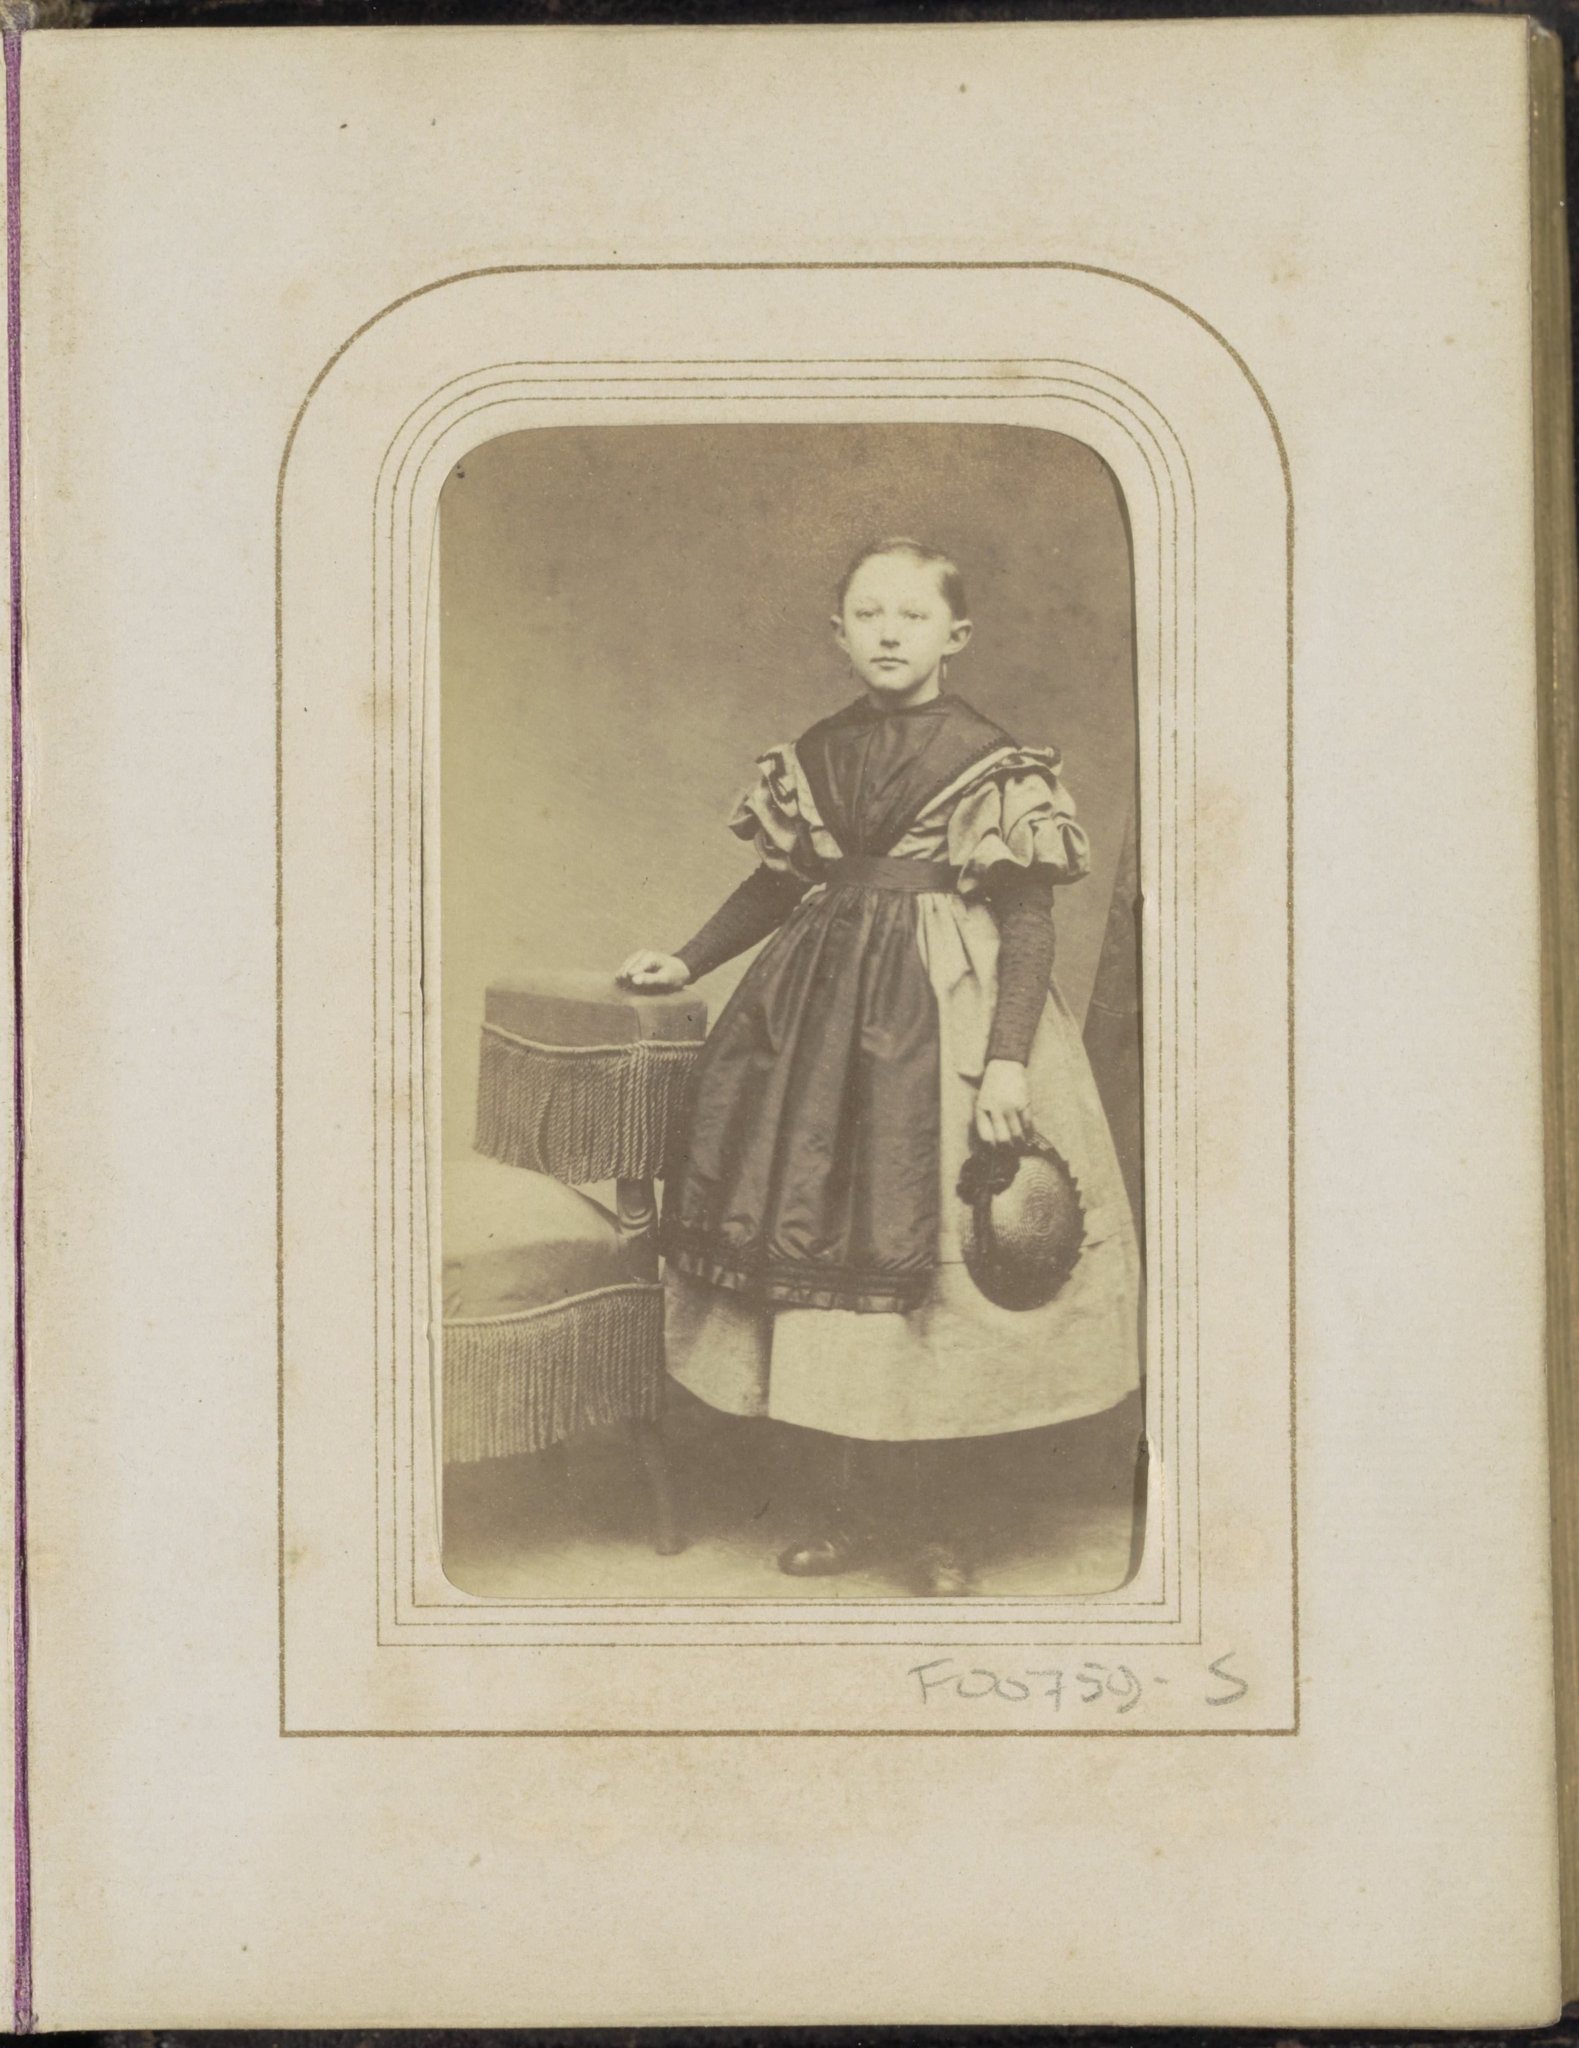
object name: photograph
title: Portret van een meisje met een schort en een hoed in de hand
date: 1863-1885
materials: cardboard, paper, photographic support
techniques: albumen print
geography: utrecht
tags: studio requisites ~ photographer, apron (+ girls' clothes), historical persons, head-gear: hat, utrecht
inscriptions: address: ‘Utrecht, Zonstraat, Wijk G No.401’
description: Onderdeel van Fotoalbum van een Nederlandse familie met 50 cartes-de-visite.